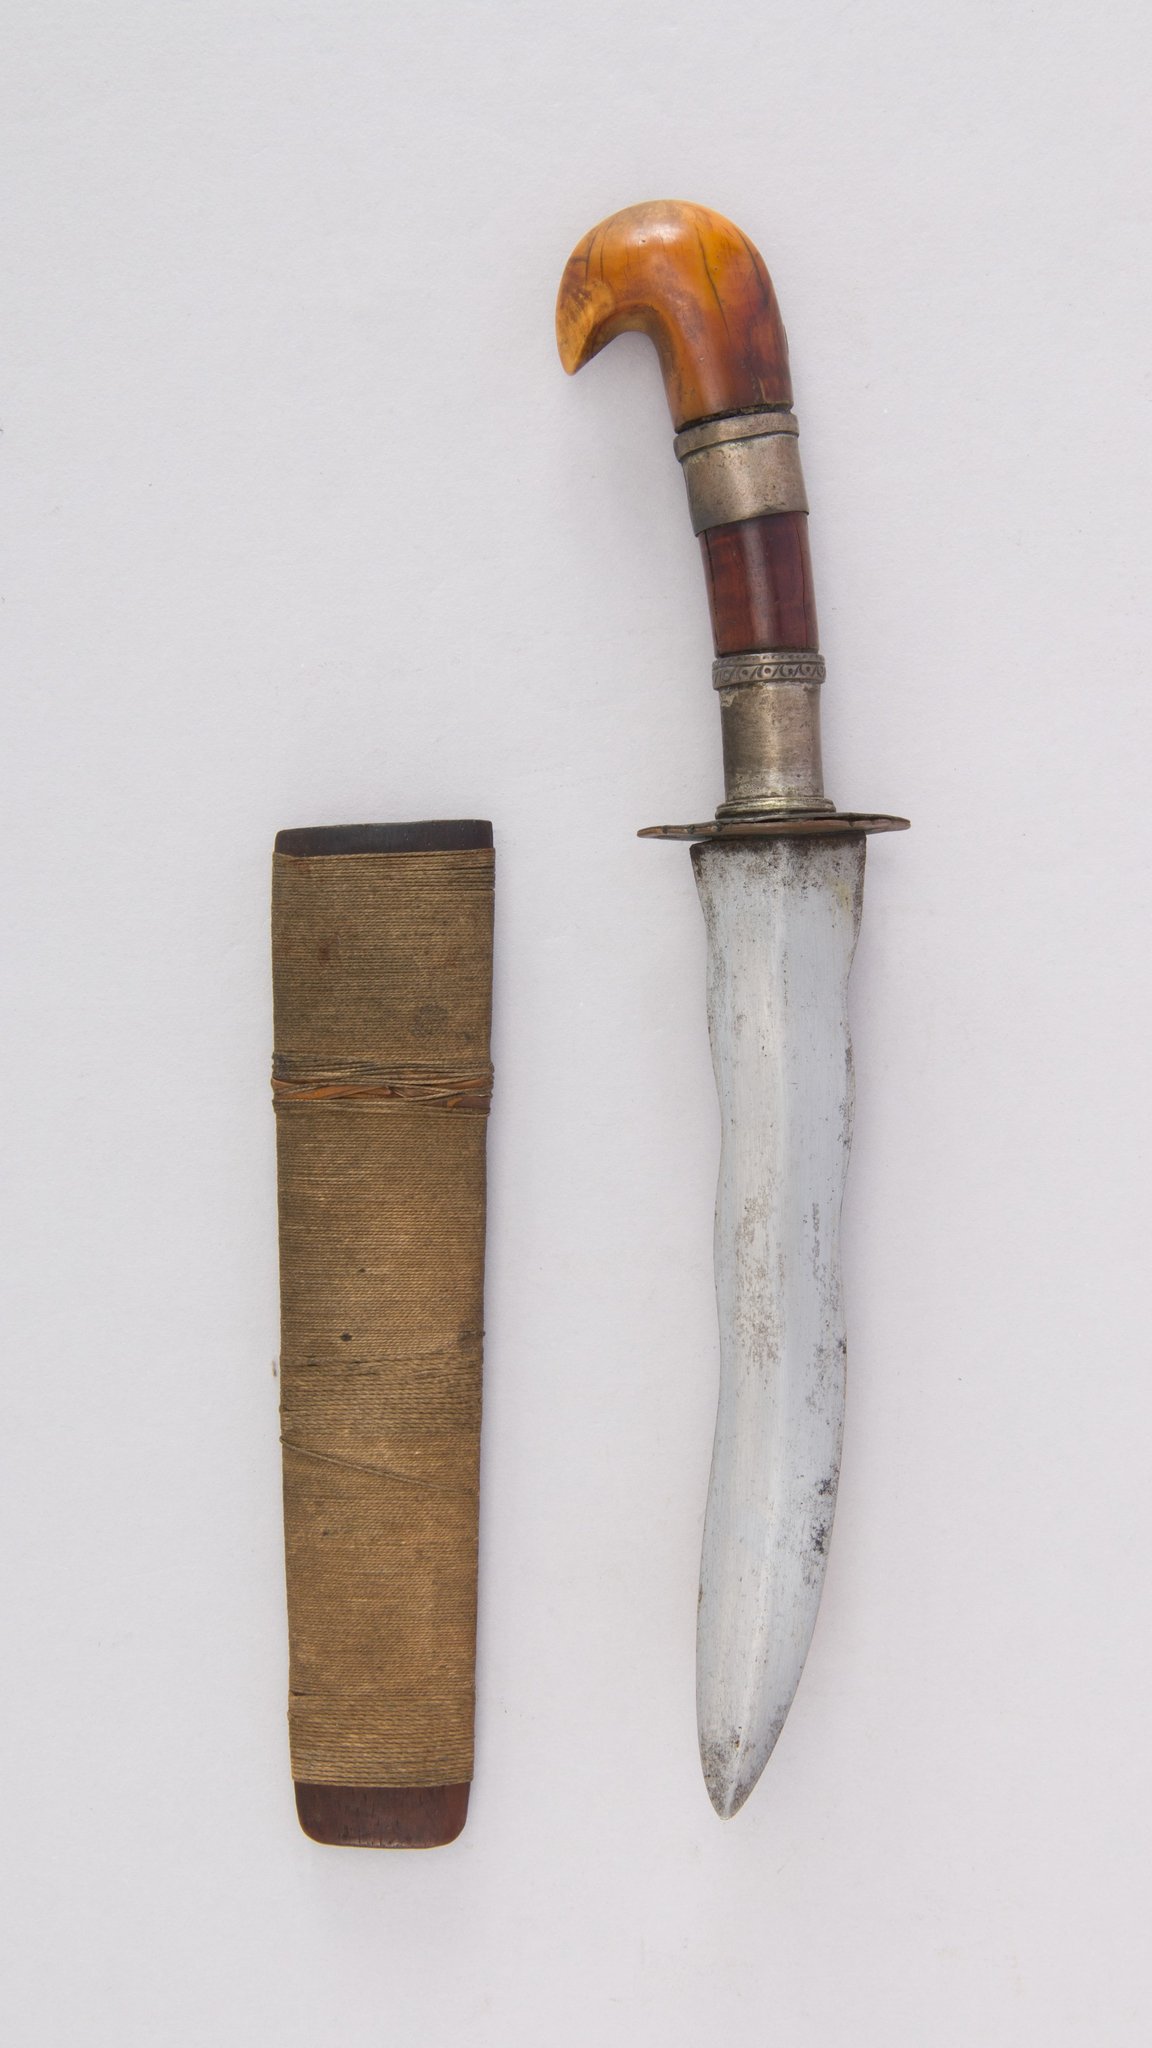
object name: dagger with sheath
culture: philippine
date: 1801-1900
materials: copper, ivory, silver, steel, textile, wood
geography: philippines